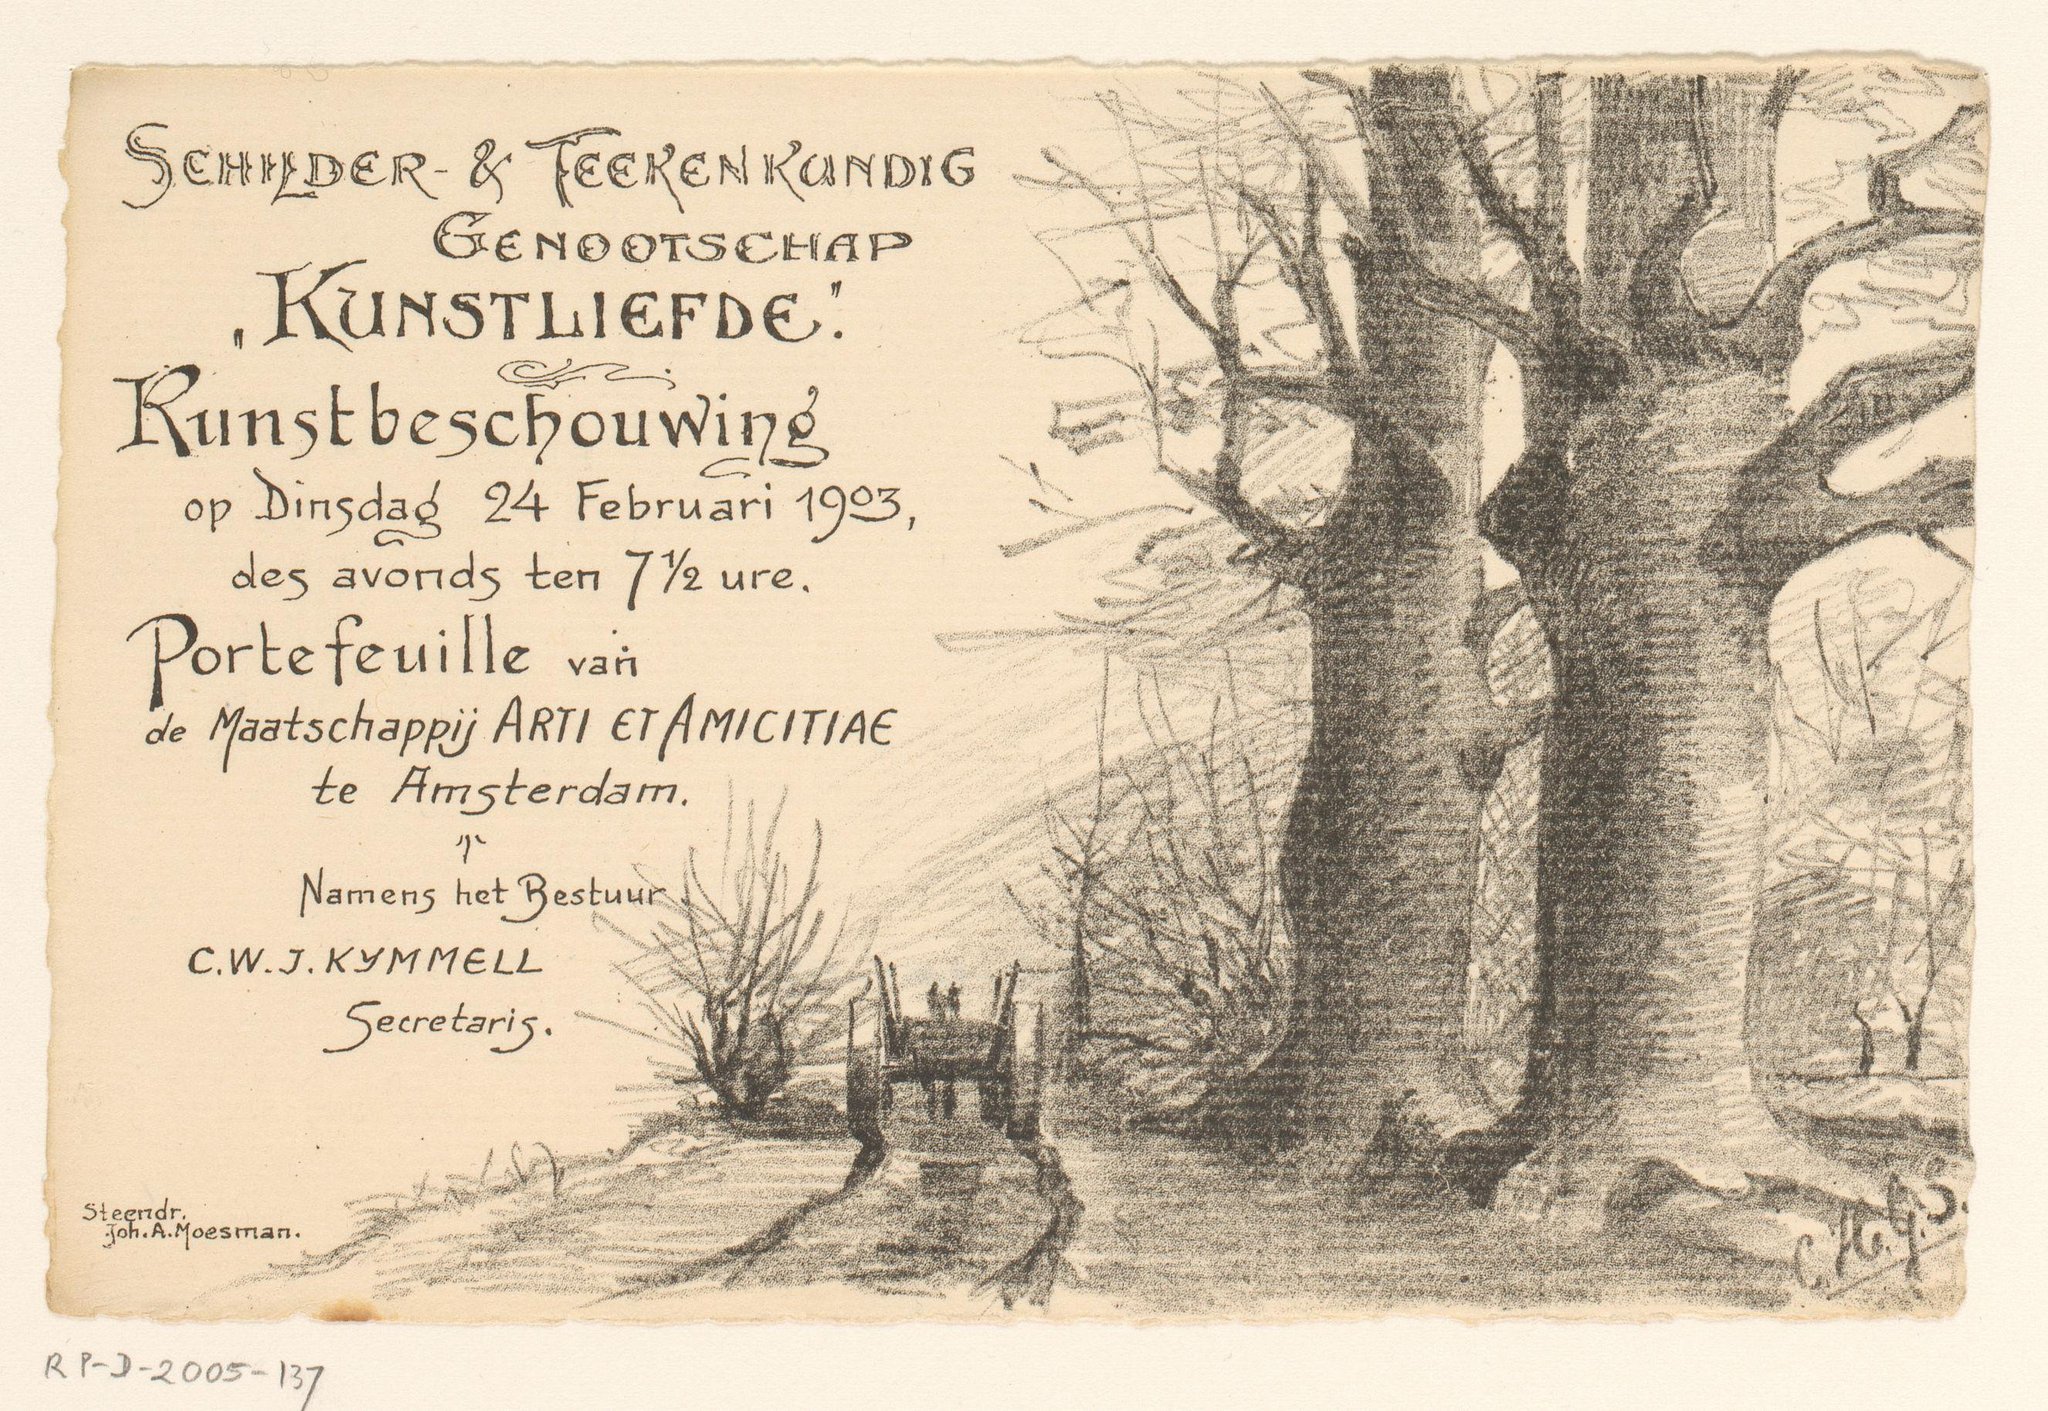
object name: print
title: Uitnodiging van Schilder- en Teekenkundig Genootschap "Kunstliefde" voor een kunstbeschouwing, 24 februari 1903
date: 1902-1903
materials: paper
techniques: lithograph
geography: utrecht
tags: criticizing and discussing art, art criticism, circle, club of artists, collecting and exhibiting products of the fine arts, forest path or lane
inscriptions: collector's mark: Lugt 2228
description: Kar op weg langs bos. Uitnodiging van Schilder- en Teekenkundig Genootschap "Kunstliefde" voor een kunstbeschouwing op 24 februari 1903 van de portefeuille van de Maatschappij Arti et Amicitiae te Amsterdam.